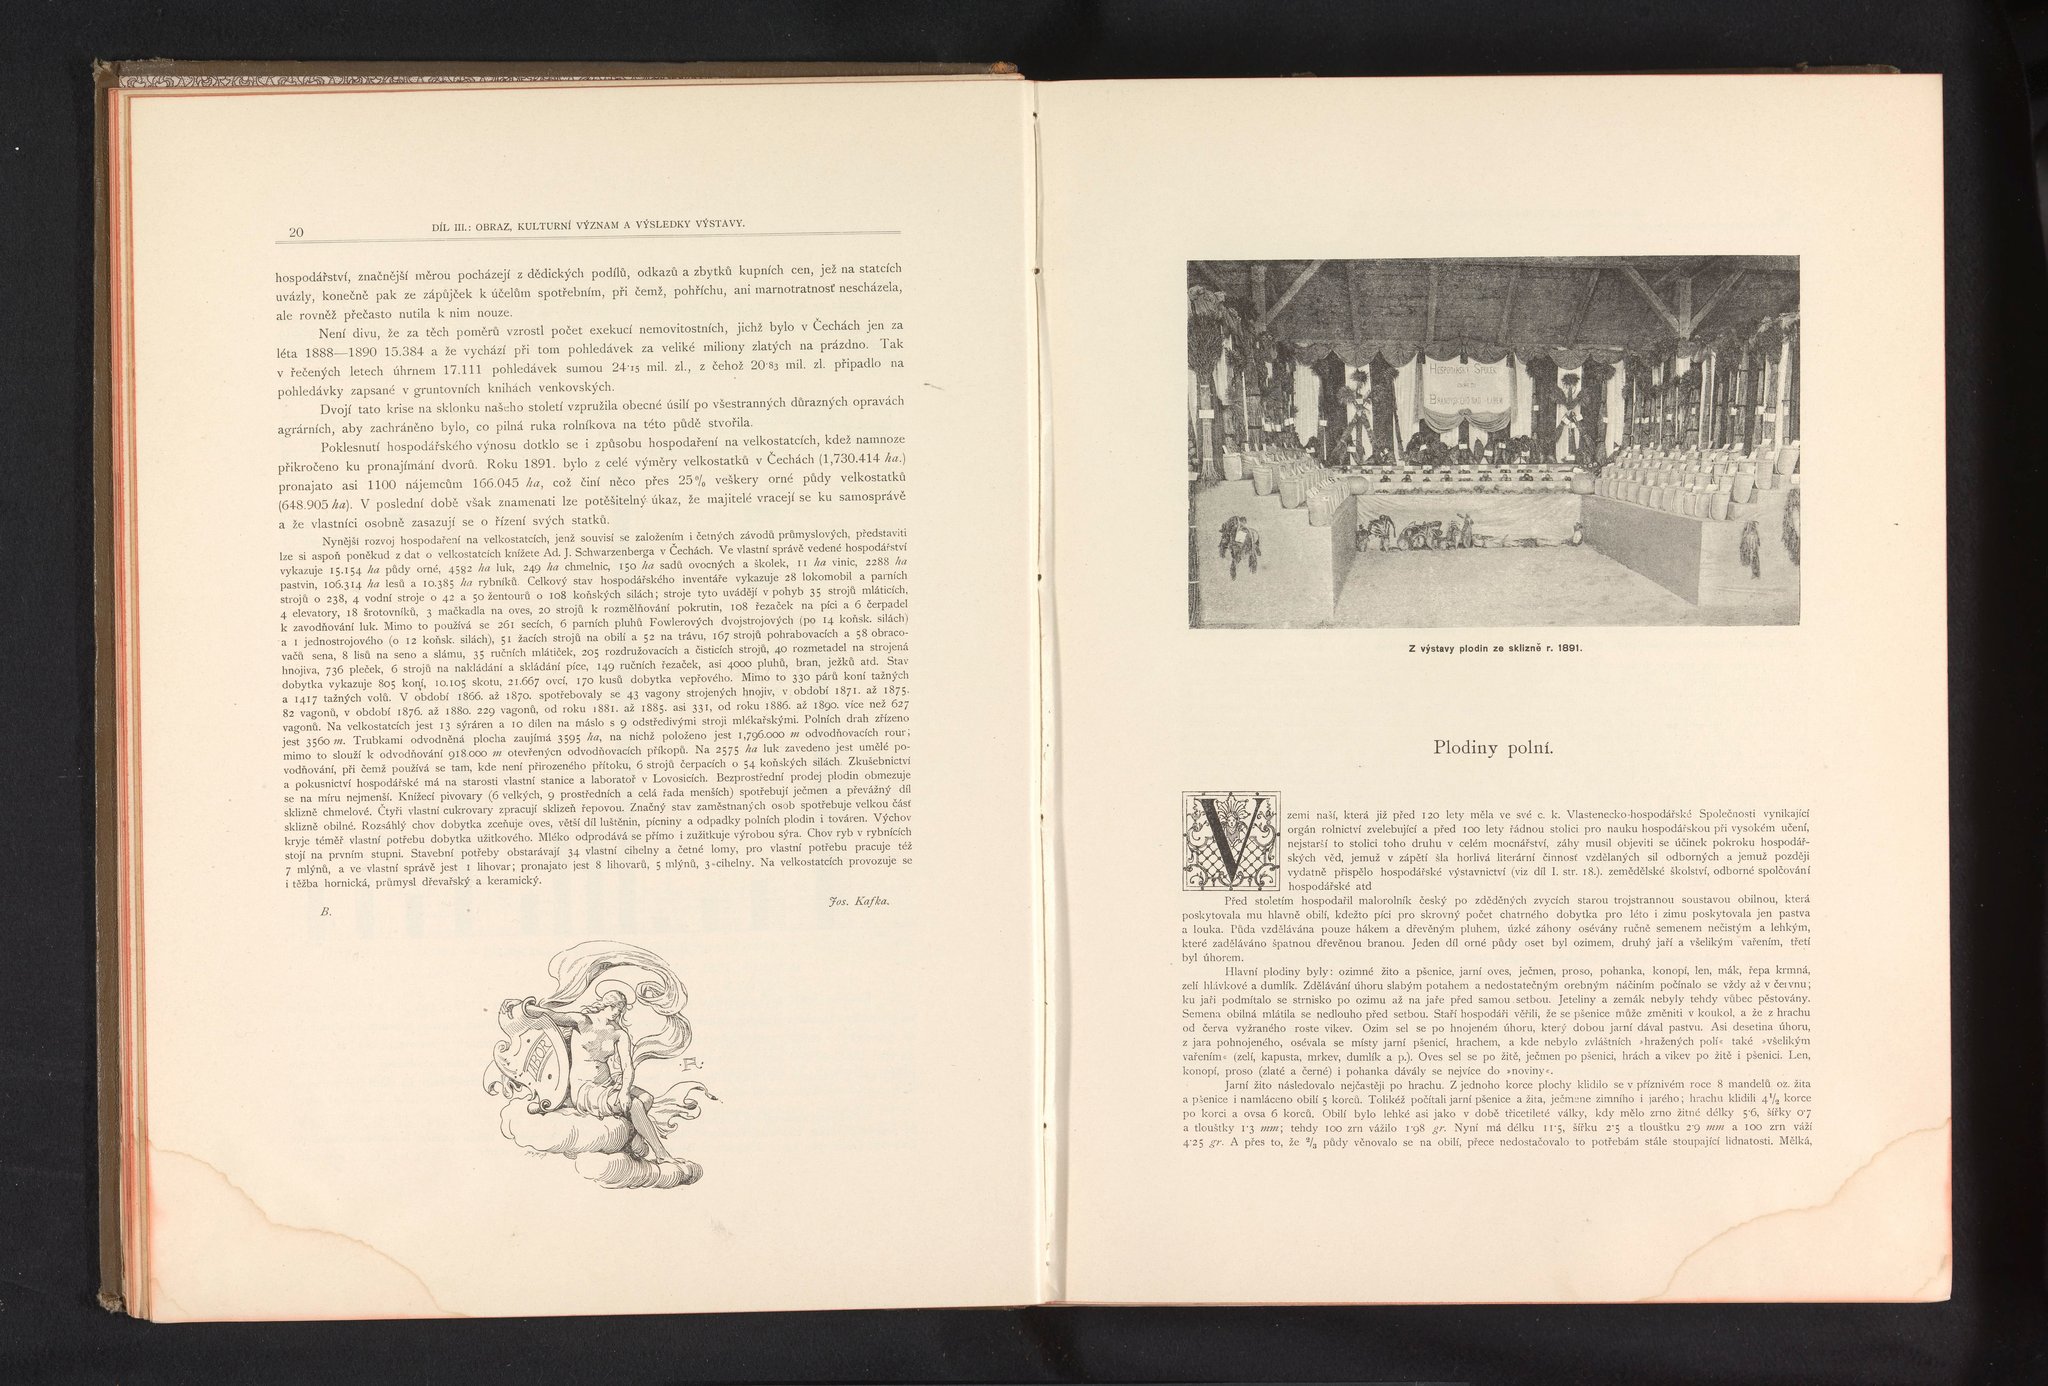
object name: page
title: Z výstavny plodin ze sklizne r. 1891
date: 1891-1895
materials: paper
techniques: autotype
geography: prague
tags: harvest